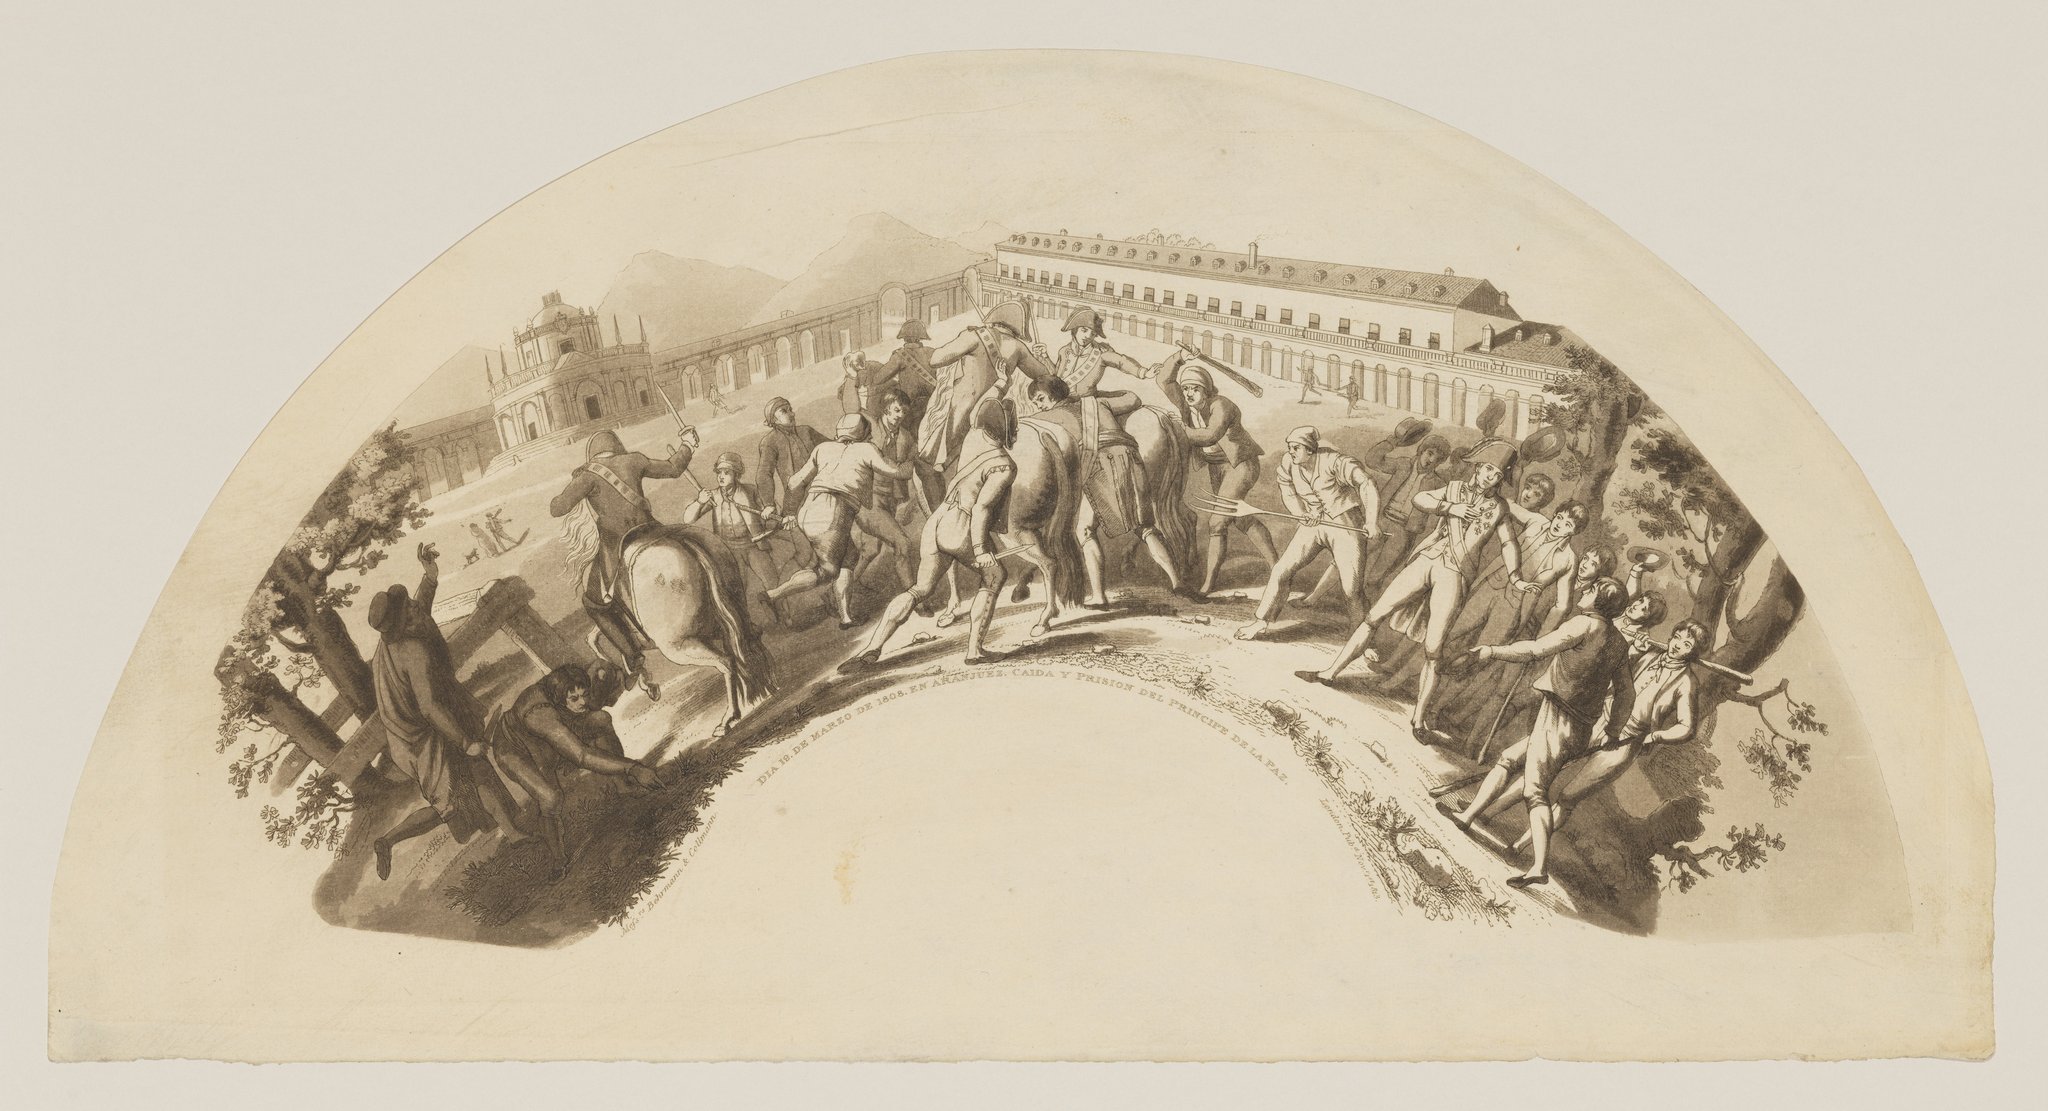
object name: print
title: Dia 19 de Marzo de 1808, en Aranjuez, Caida y Prision del Principe de la Paz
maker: anonymous, british, early 19th century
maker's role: artist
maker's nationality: british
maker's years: 1800-1850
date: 1813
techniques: aquatint, etching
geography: england